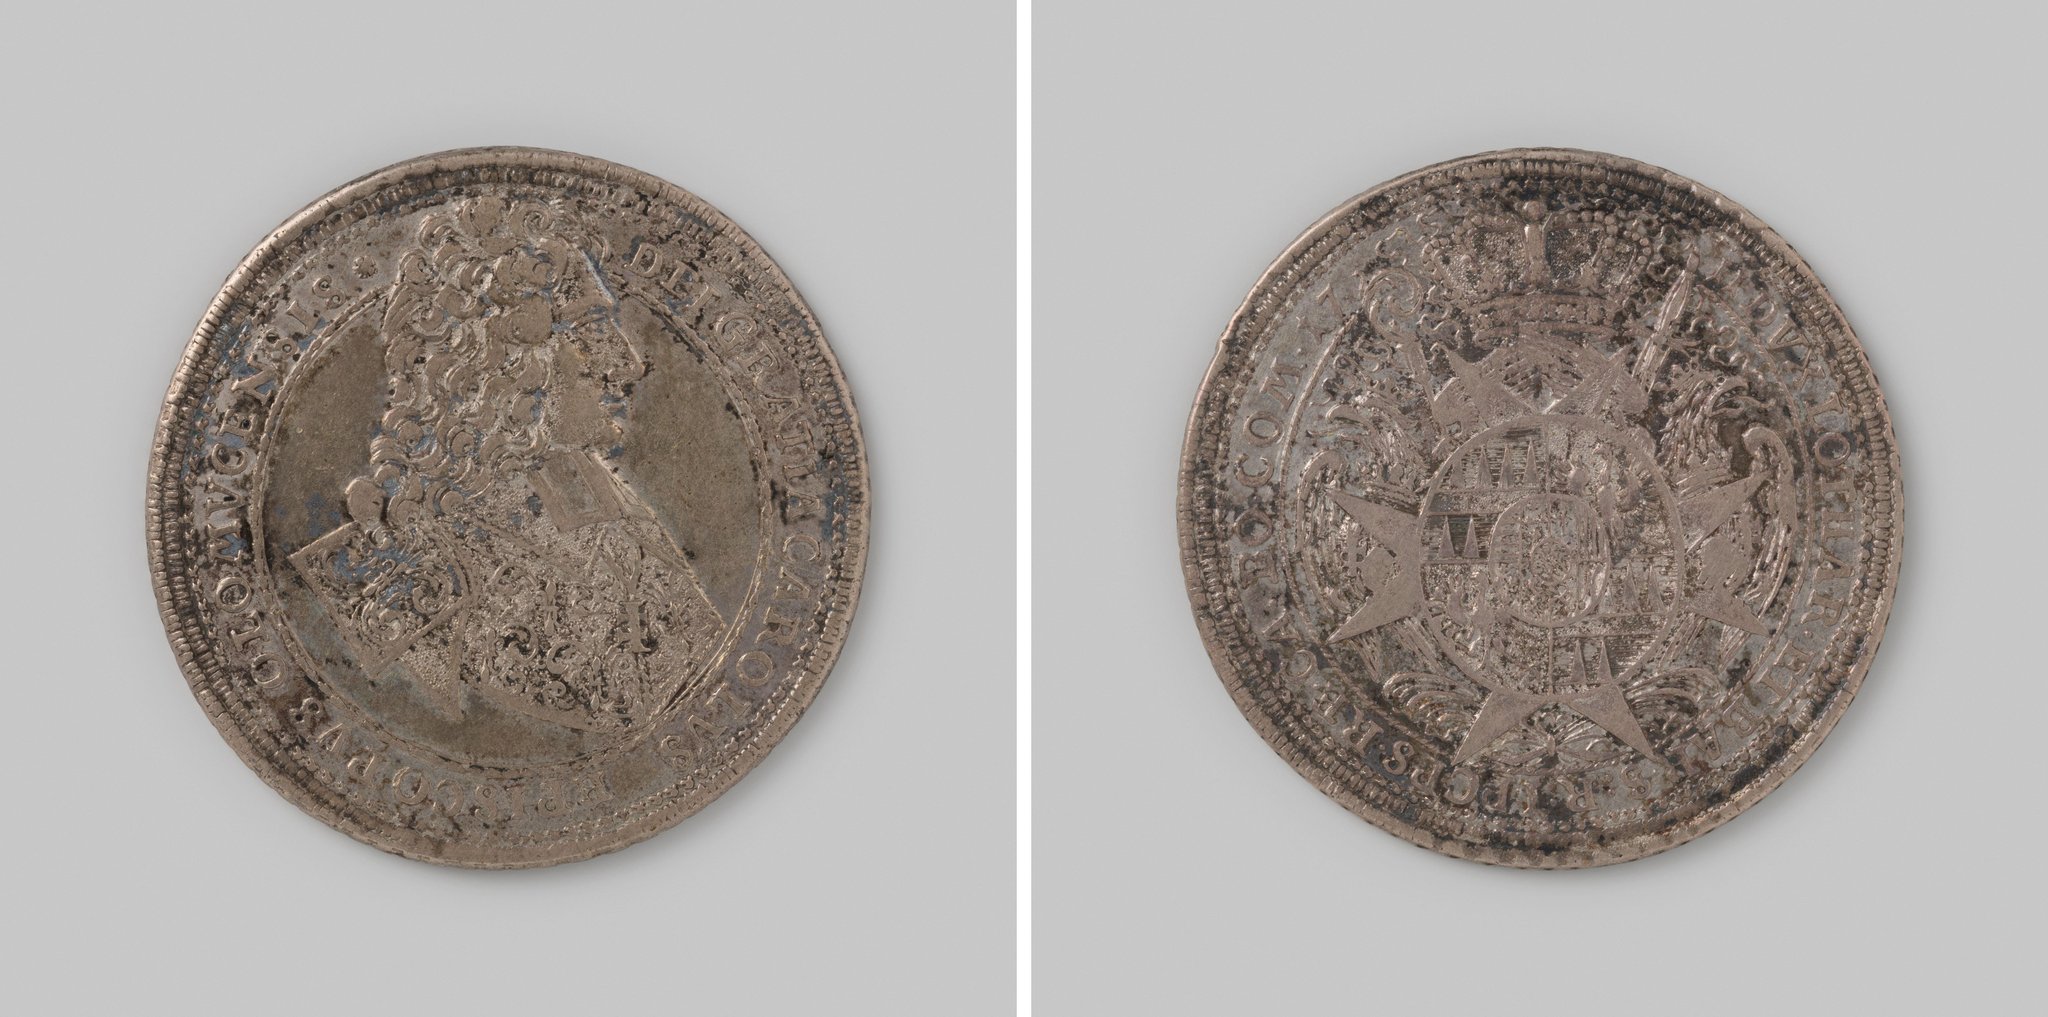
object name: coin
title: Taler uit het bisdom Olmutz van Karel III Jozef van Lotharingen, 1711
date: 1711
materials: silver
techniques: striking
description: Zilveren munt. Voorzijde: borstbeeld van de bisschop naar rechts. Keerzijde: op gekruiste bisschopstaf en zwaard dubbelkoppige gekroonde adelaar met gespreide vleugels, waarboven kroon. Op de adelaar een kruis, waarop een ovaal samengesteld wapenschild. Jaartal rondom de kroon bovenaan in het omschrift. Kartelrand.